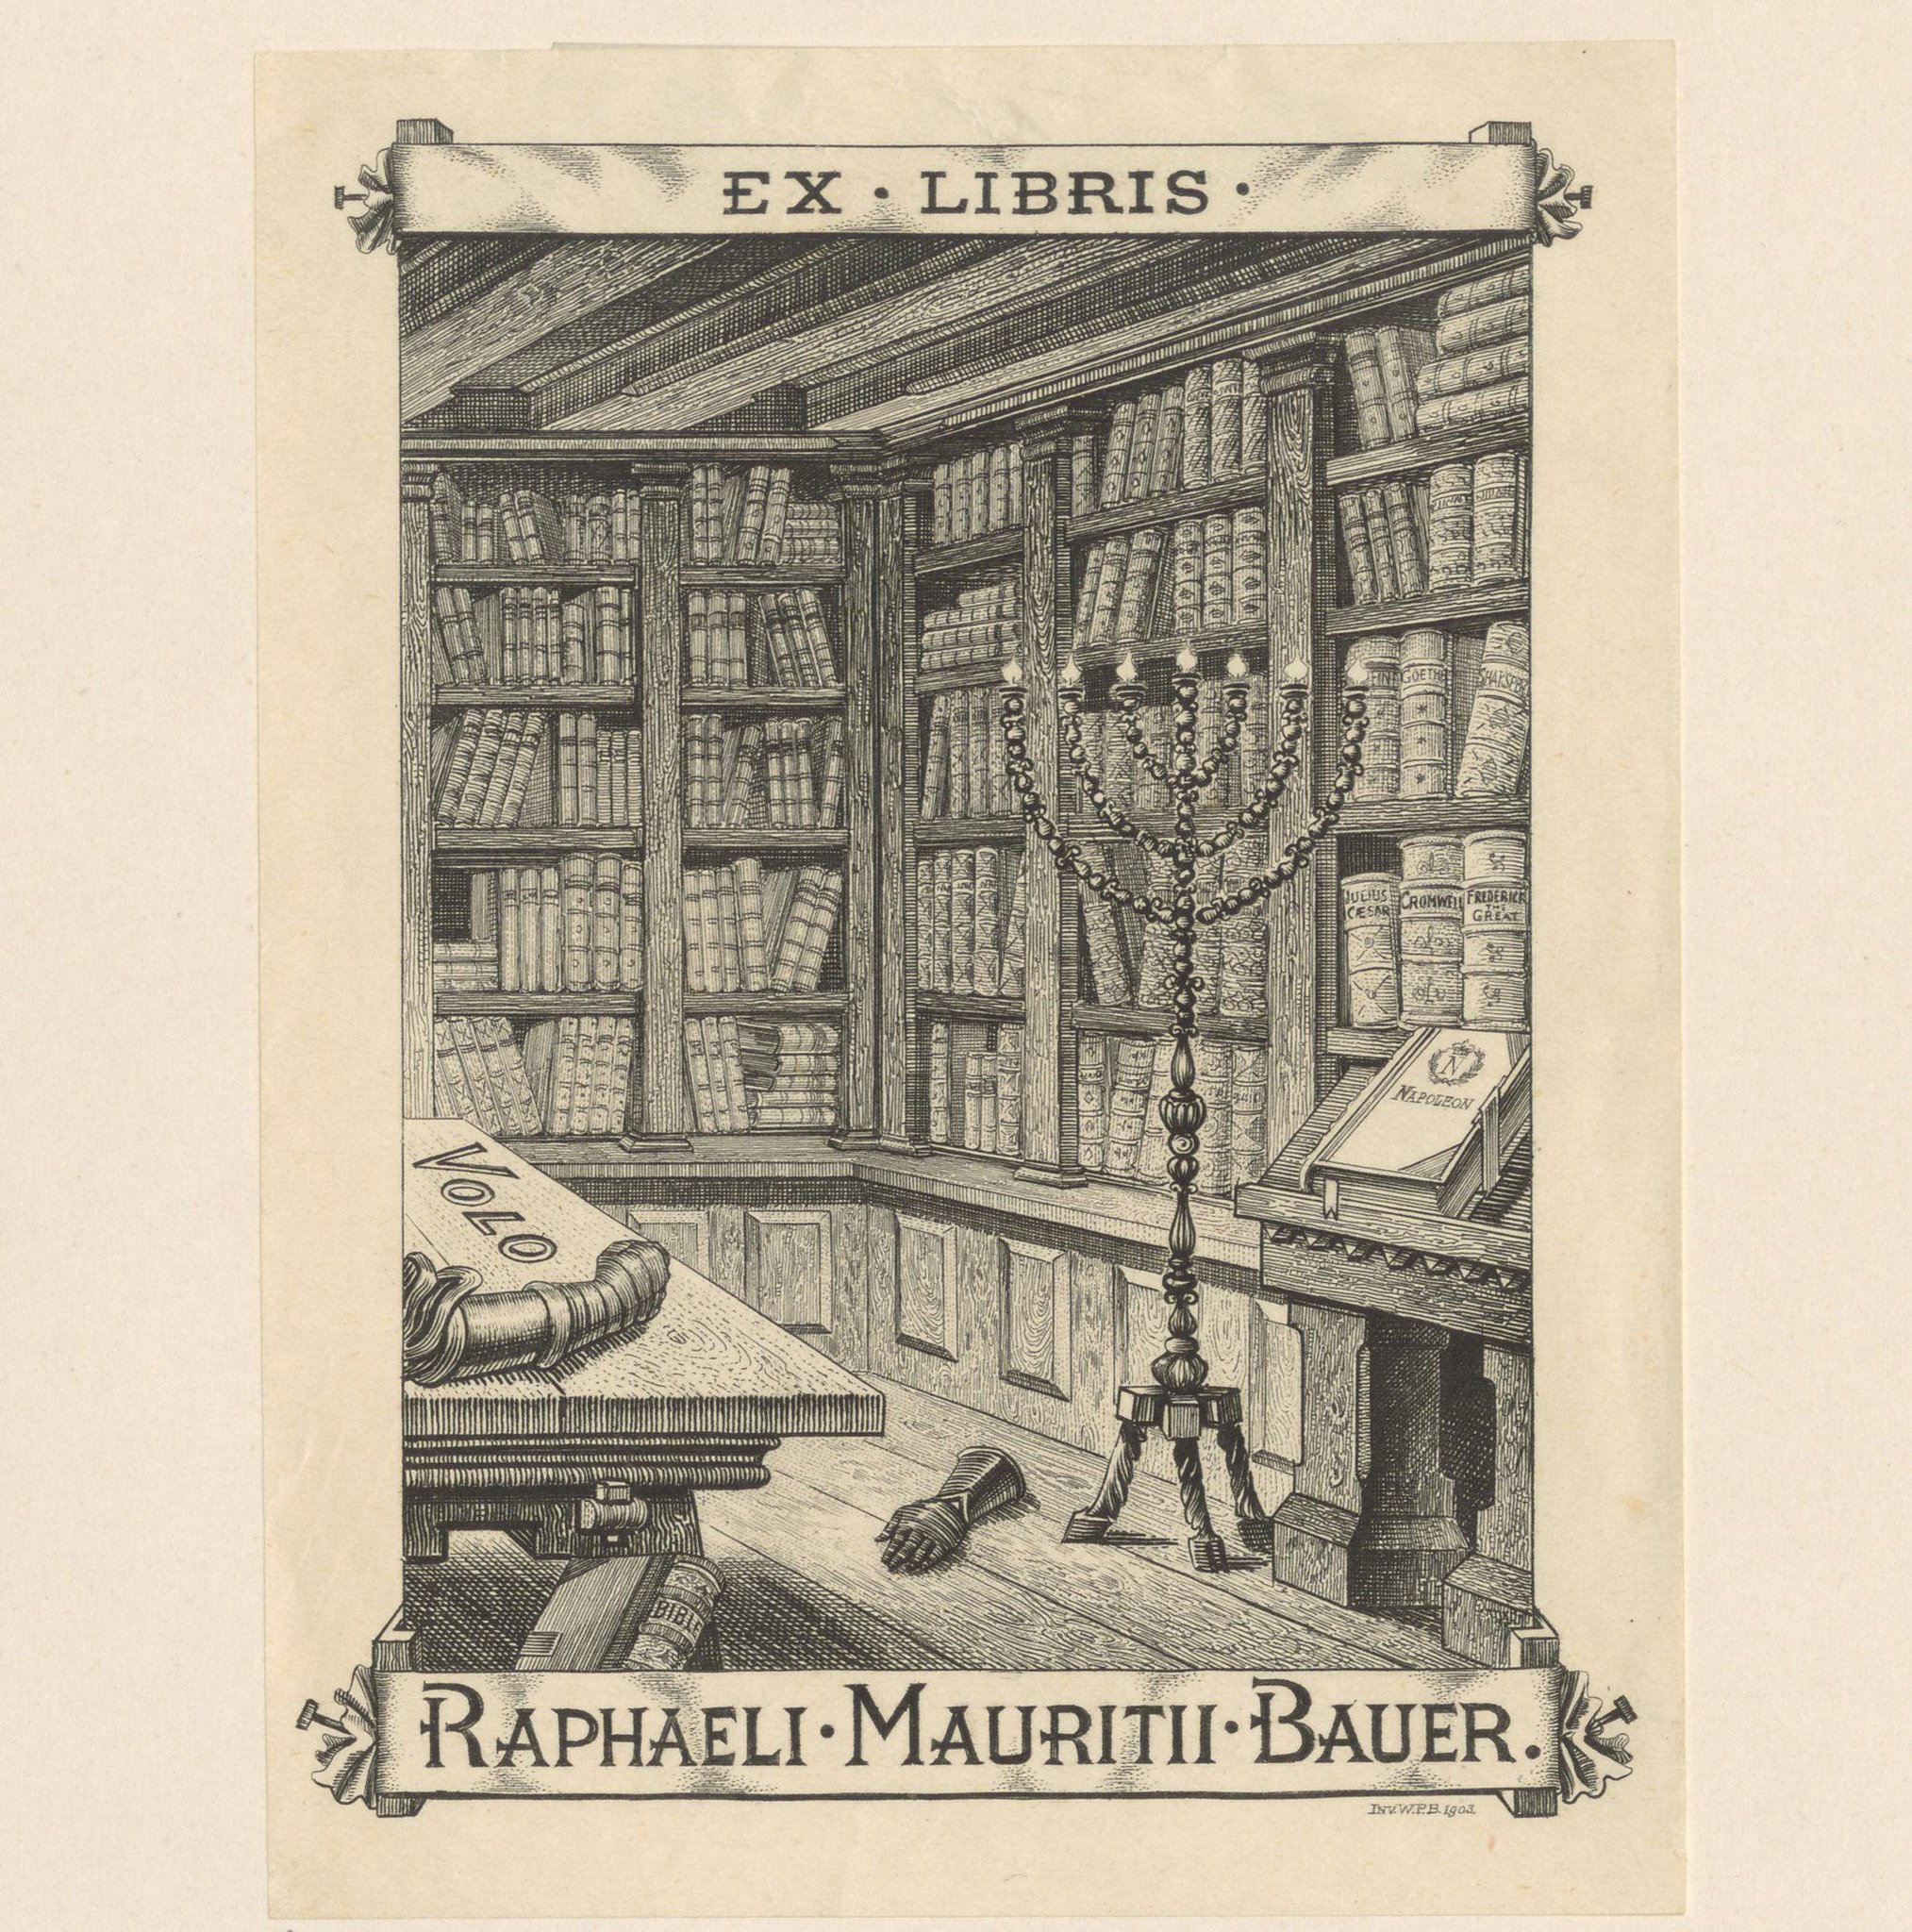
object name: bookplate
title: Ex libris Raphaeli Mauritii Bauer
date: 1903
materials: paper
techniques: etching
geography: england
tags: augsburg, bookshelves, book, seven lamps ~ 'menorah'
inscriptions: date